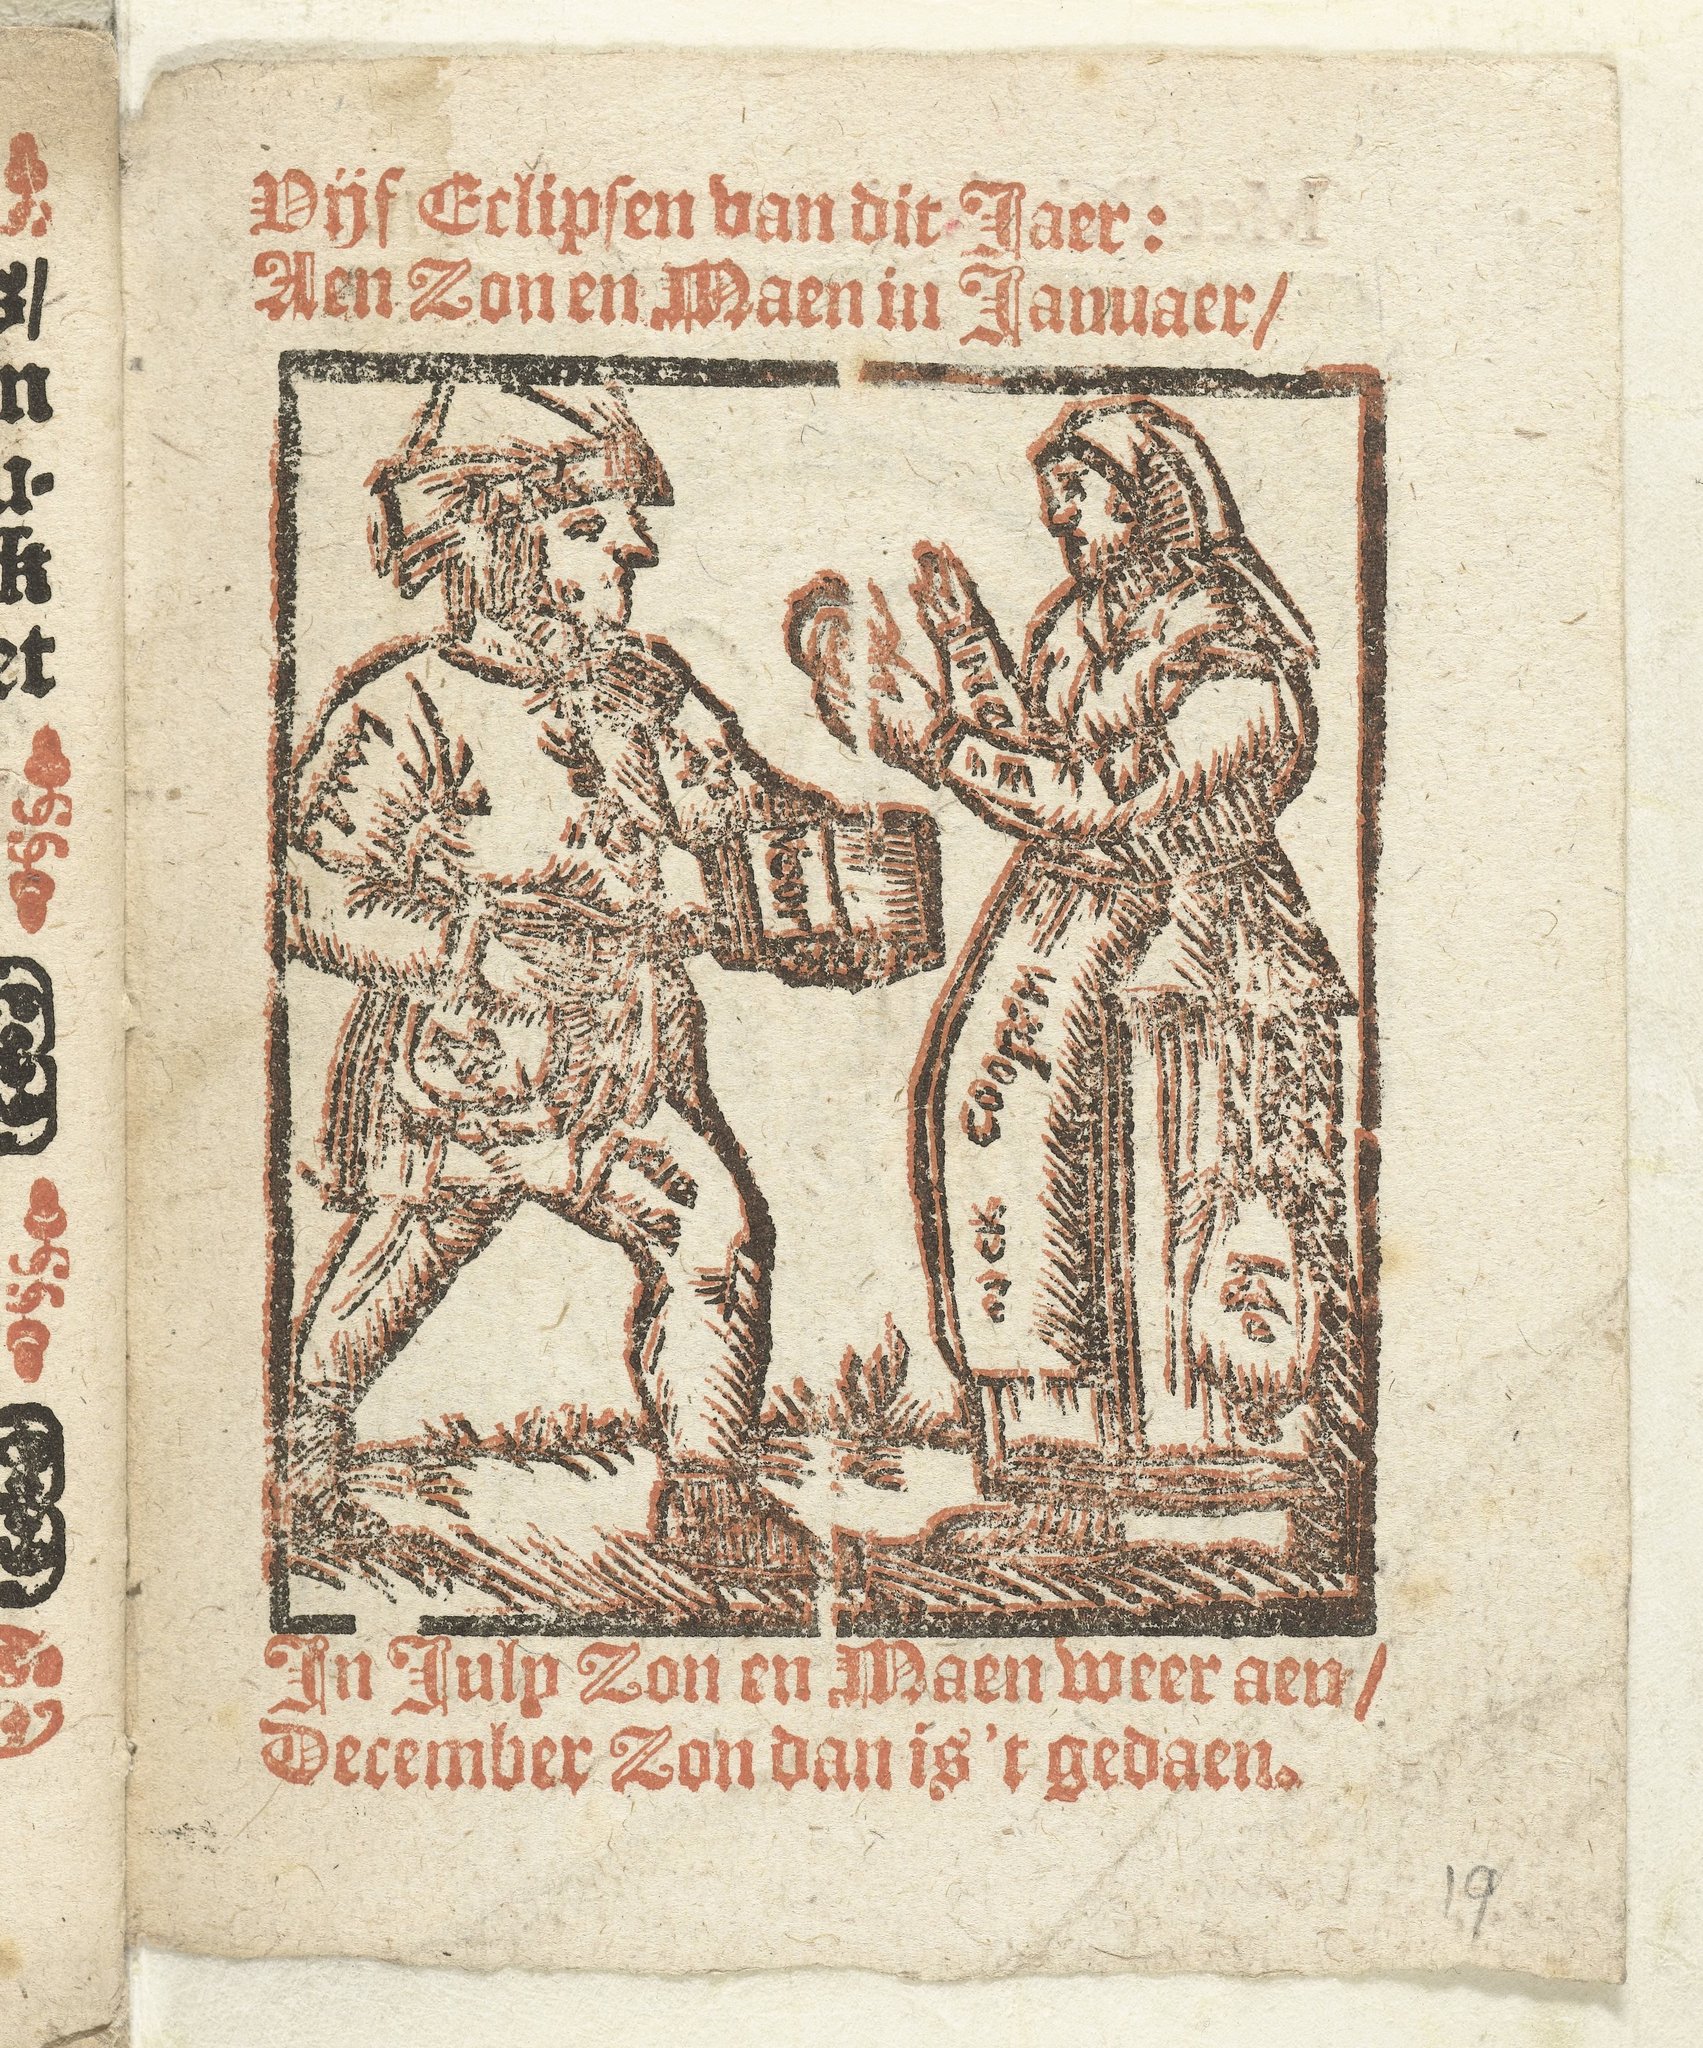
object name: print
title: Bladzijde met staande figuren van een kramer en een vrouw, 1712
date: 1712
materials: paper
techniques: letterpress printing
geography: southern netherlands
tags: pedlar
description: Bladzijde in: Den Boeren / Oft Schapers Almanach Voor 't Schrickel Jaer ins Heeren Jesu Christi, 1712. Antwerpen: bij Wed. Slegers 1712. Exemplaar in de Rijksmuseum Research Library (signatuur: 305 G 19).